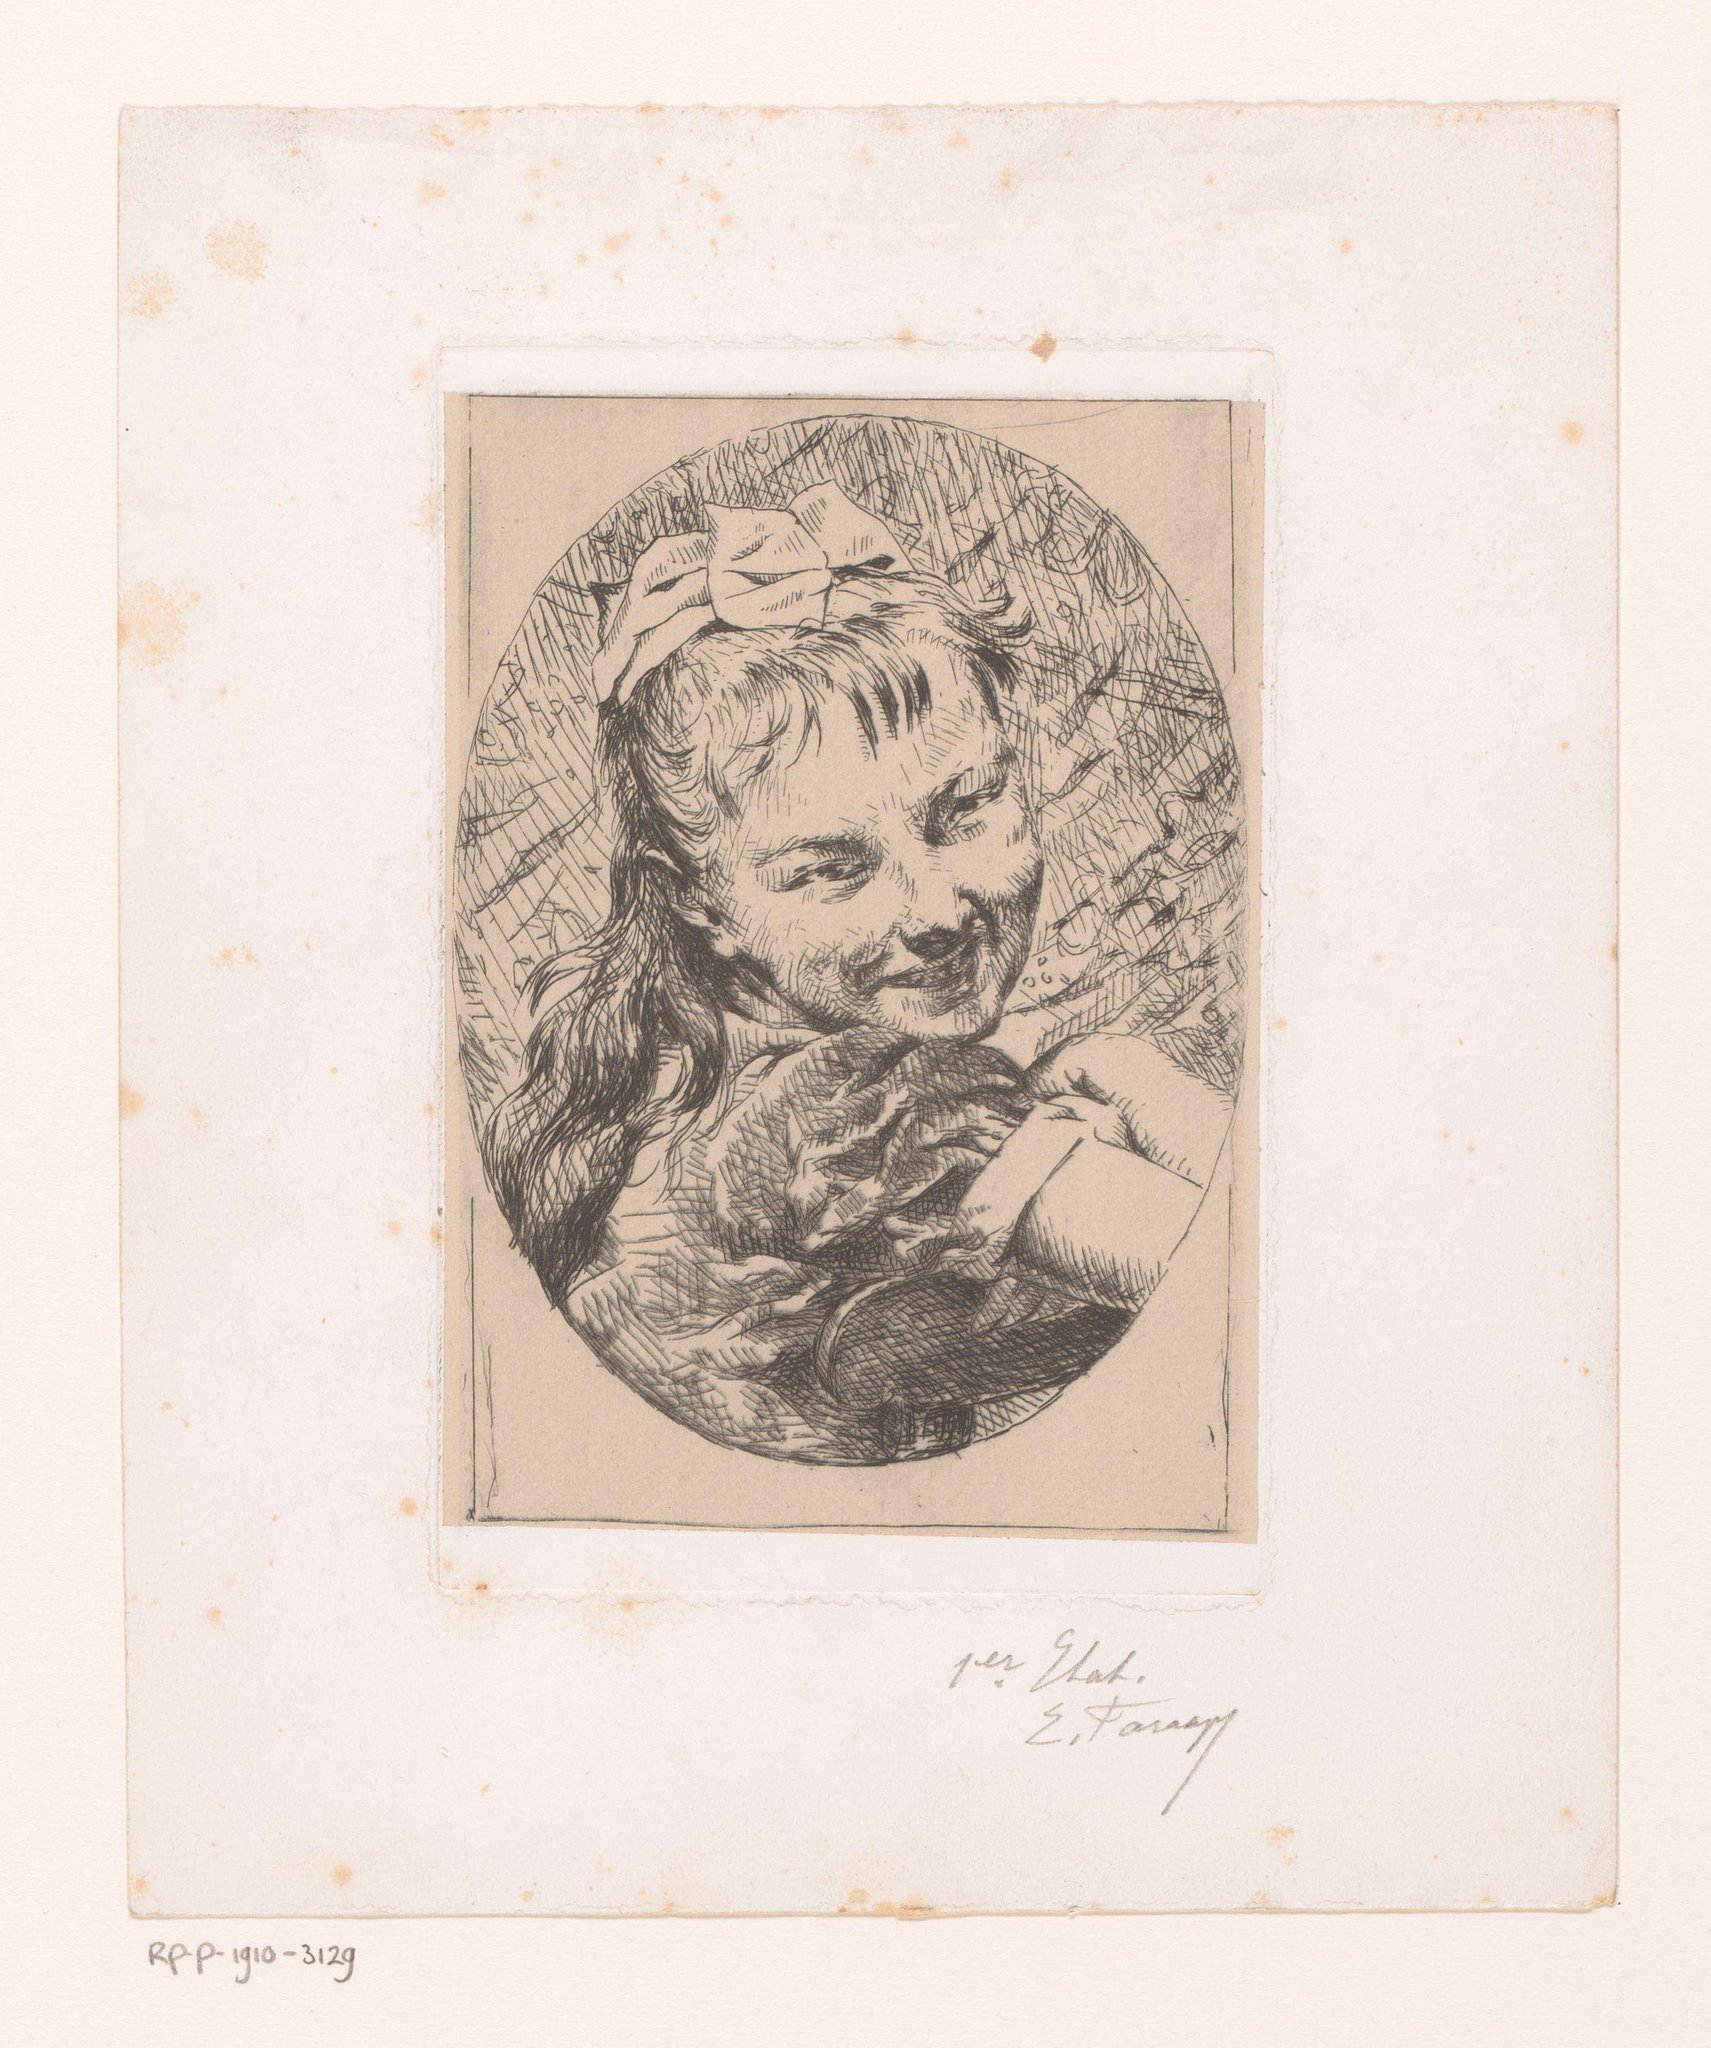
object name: print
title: Portret van een onbekend lachend meisje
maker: edgard farasyn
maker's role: print maker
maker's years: 1858-1938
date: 1868-1910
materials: paper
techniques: etching, intaglio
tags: historical persons, girl (child between toddler and youth)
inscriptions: collector's mark: Lugt 2228, inscription: ‘1er Etat’